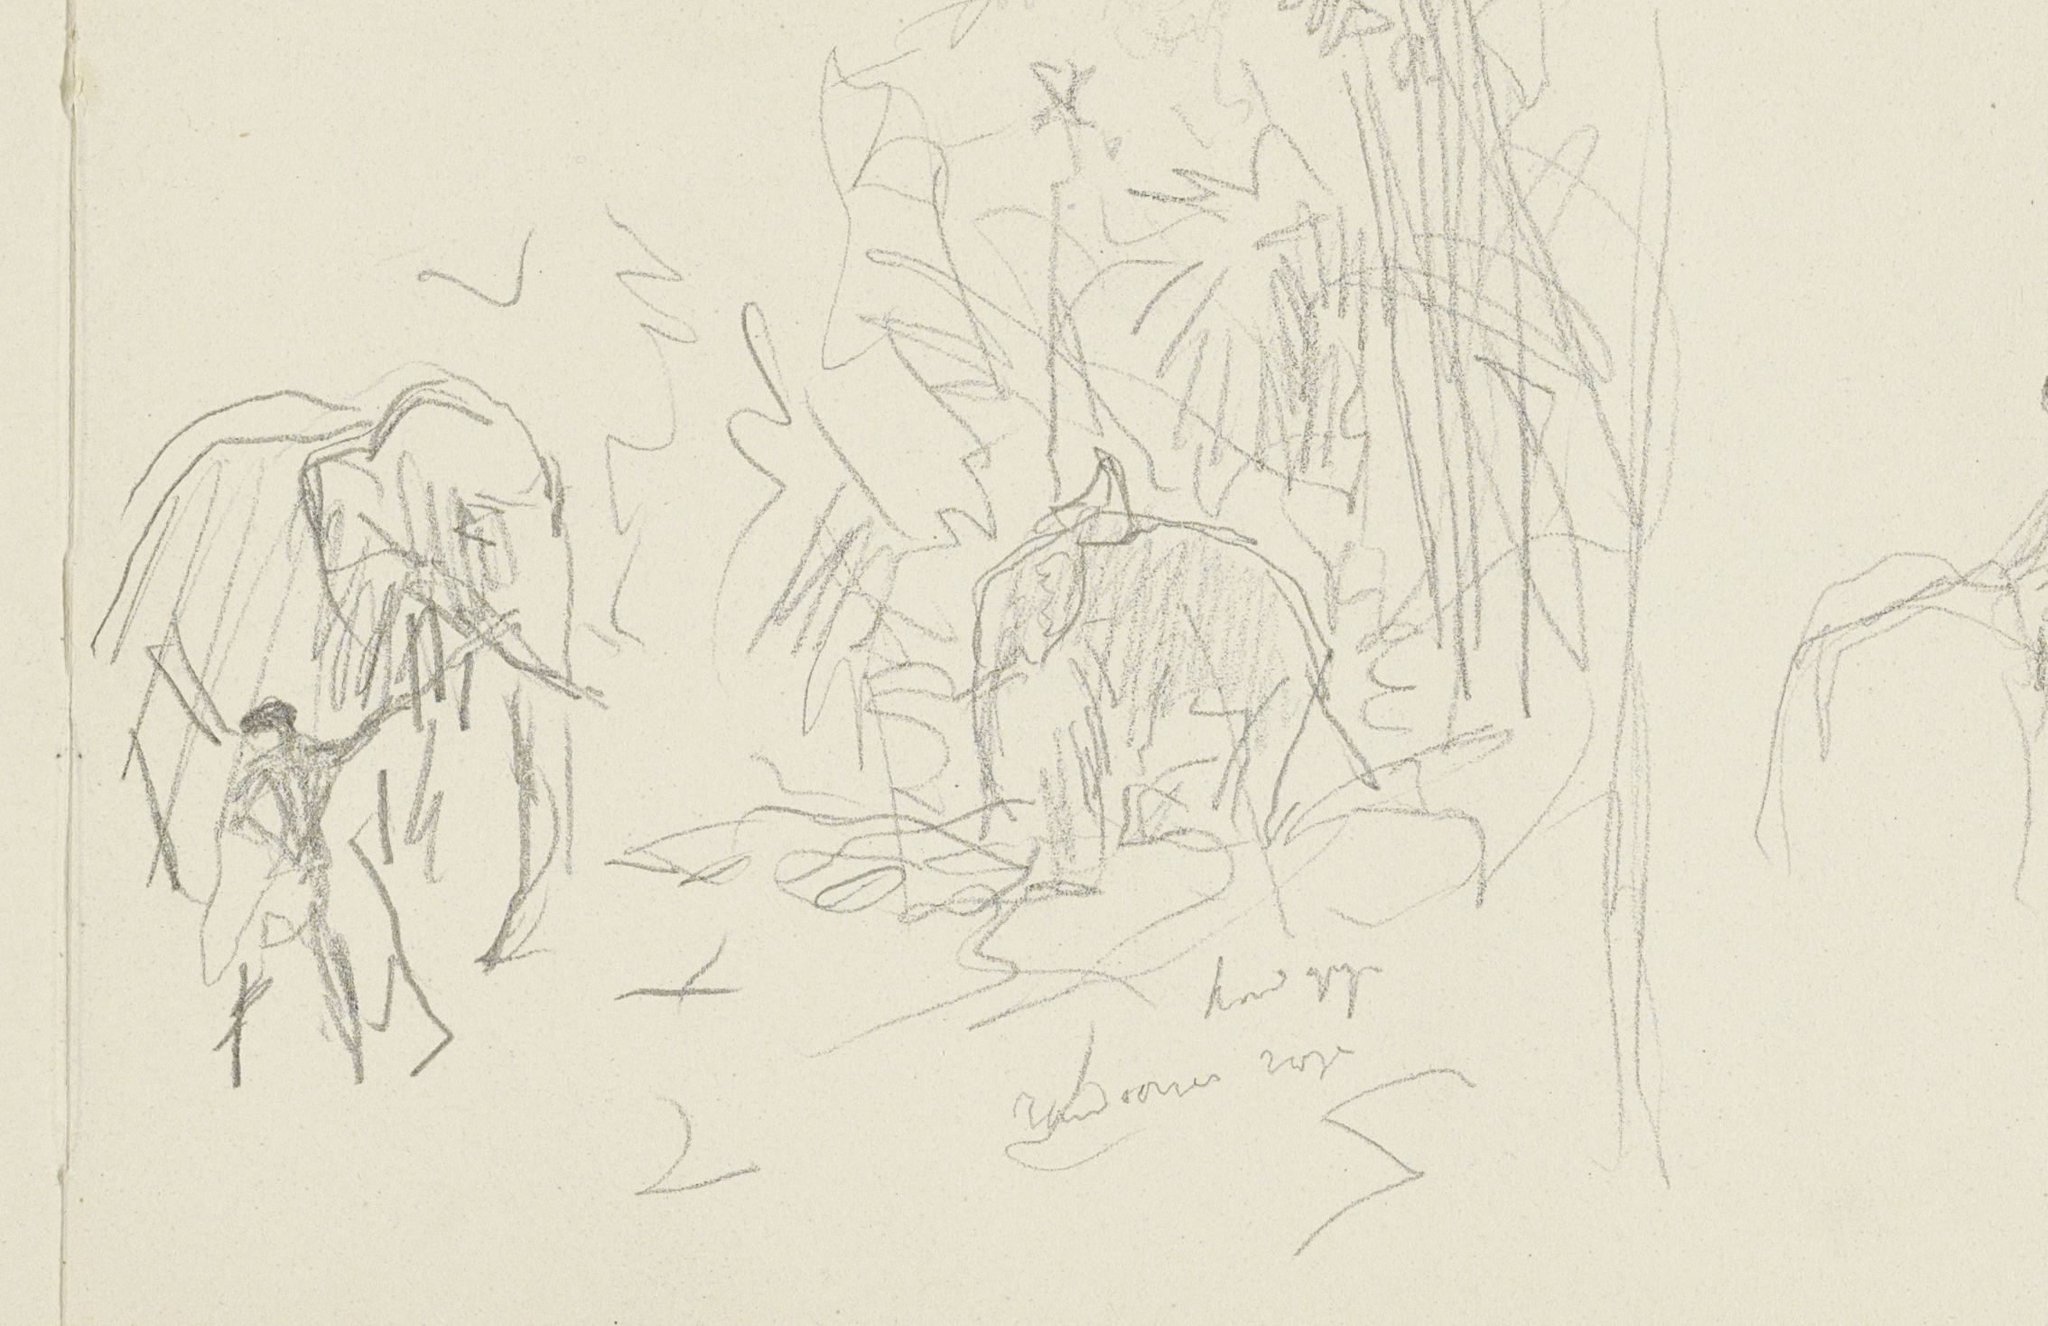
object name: sketchbook leaf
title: Olifanten in het oerwoud van India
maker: marius bauer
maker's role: draughtsman, print maker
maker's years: 1867-1932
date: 1924-1925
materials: paper, pencil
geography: india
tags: sitting figure, jungle, trunked animals: elephant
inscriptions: kleurnotitie, handgeschreven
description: Tevens een studie van een figuur op een olifant. Pagina 87 uit een schetsboek met 48 bladen.